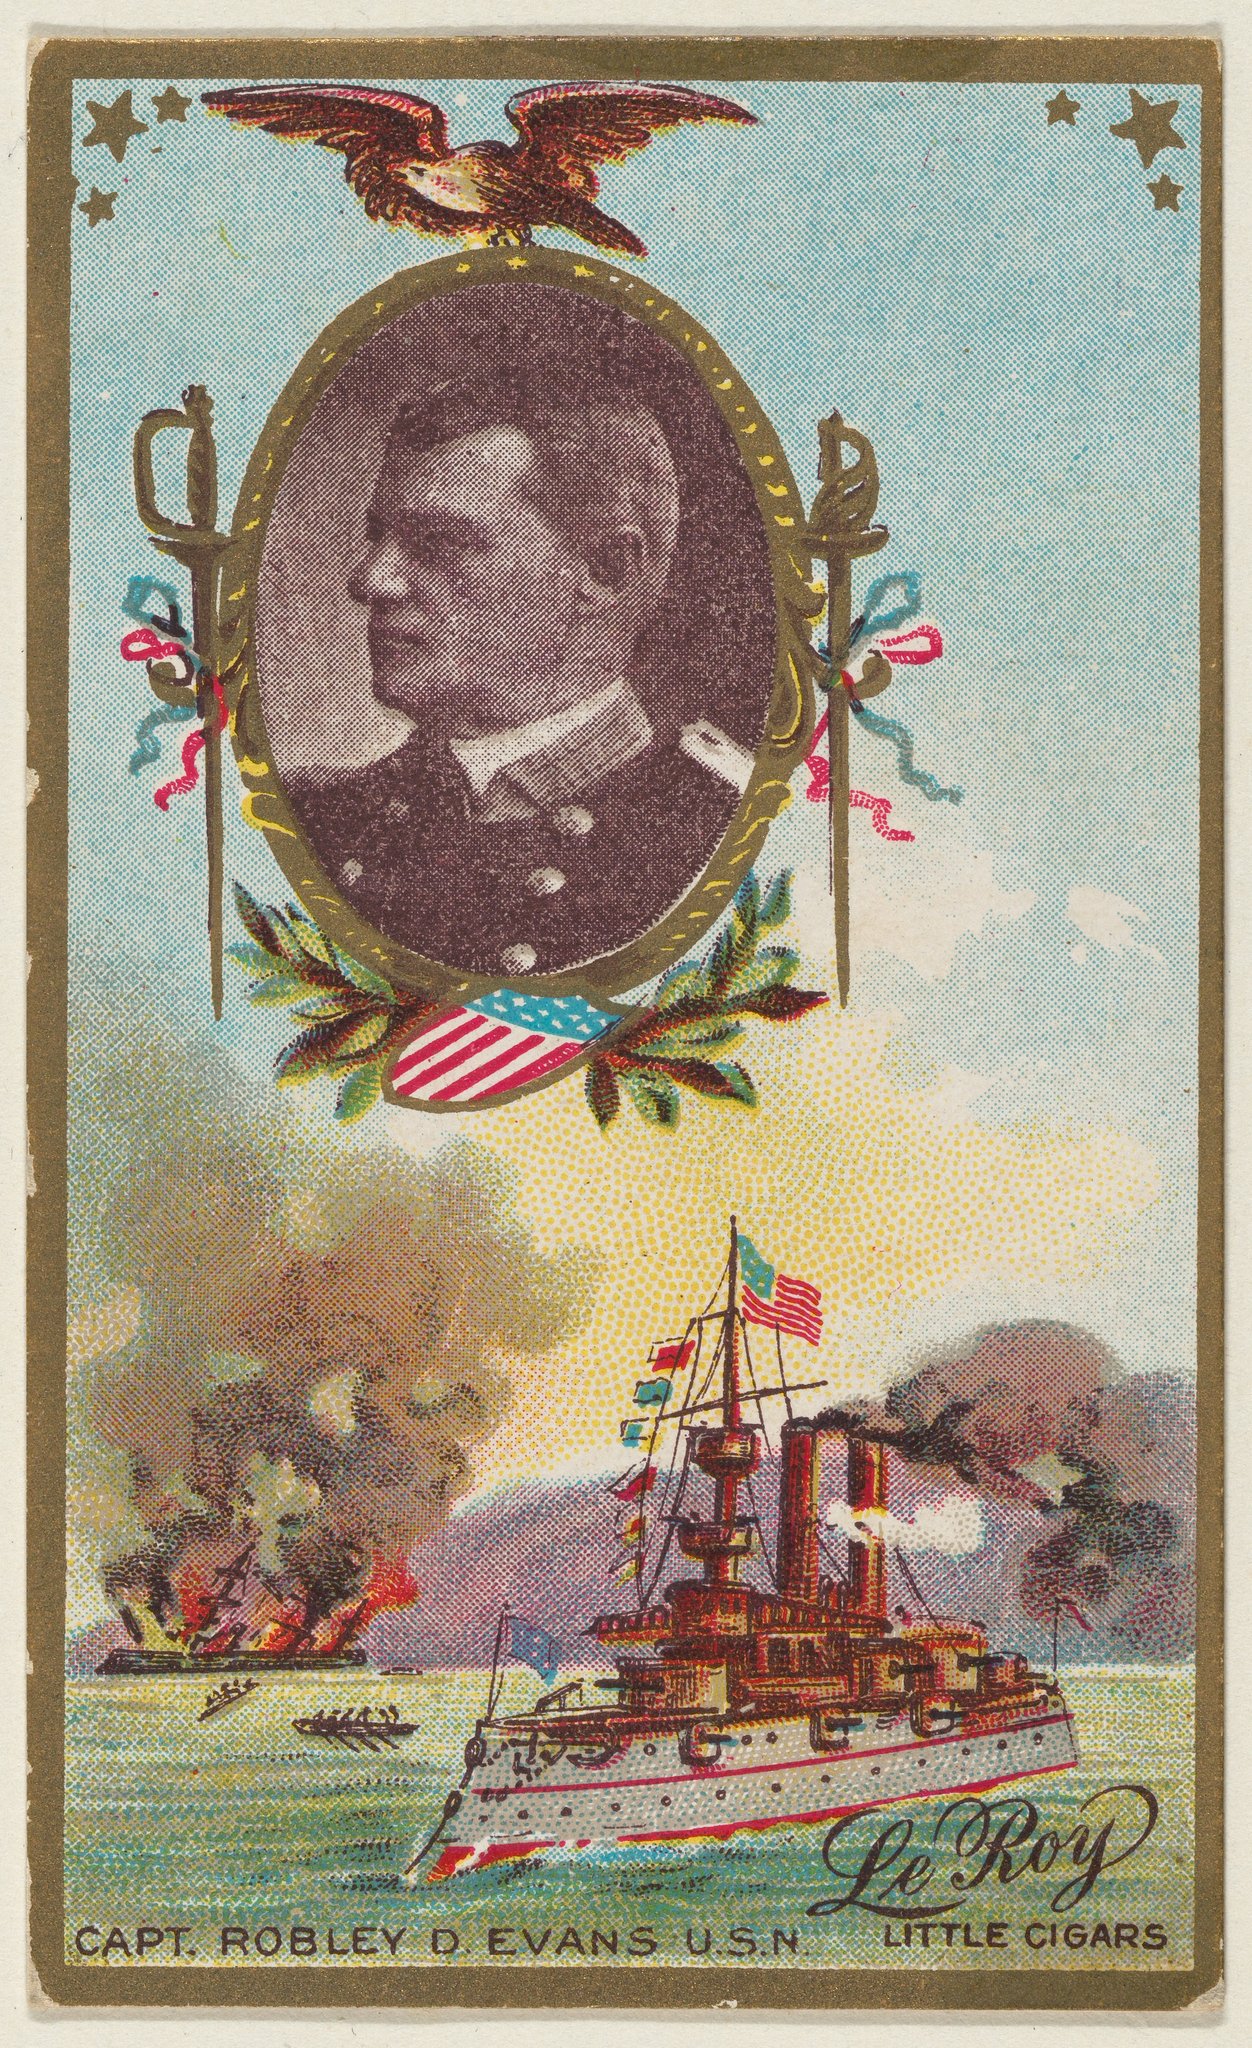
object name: print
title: Captain Robley D. Evans, U.S. Navy, from the "Generals" series (T63), issued by LeRoy Little Cigars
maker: leroy little cigars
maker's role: publisher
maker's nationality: american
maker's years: 1850-1950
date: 1898-1901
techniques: color lithograph